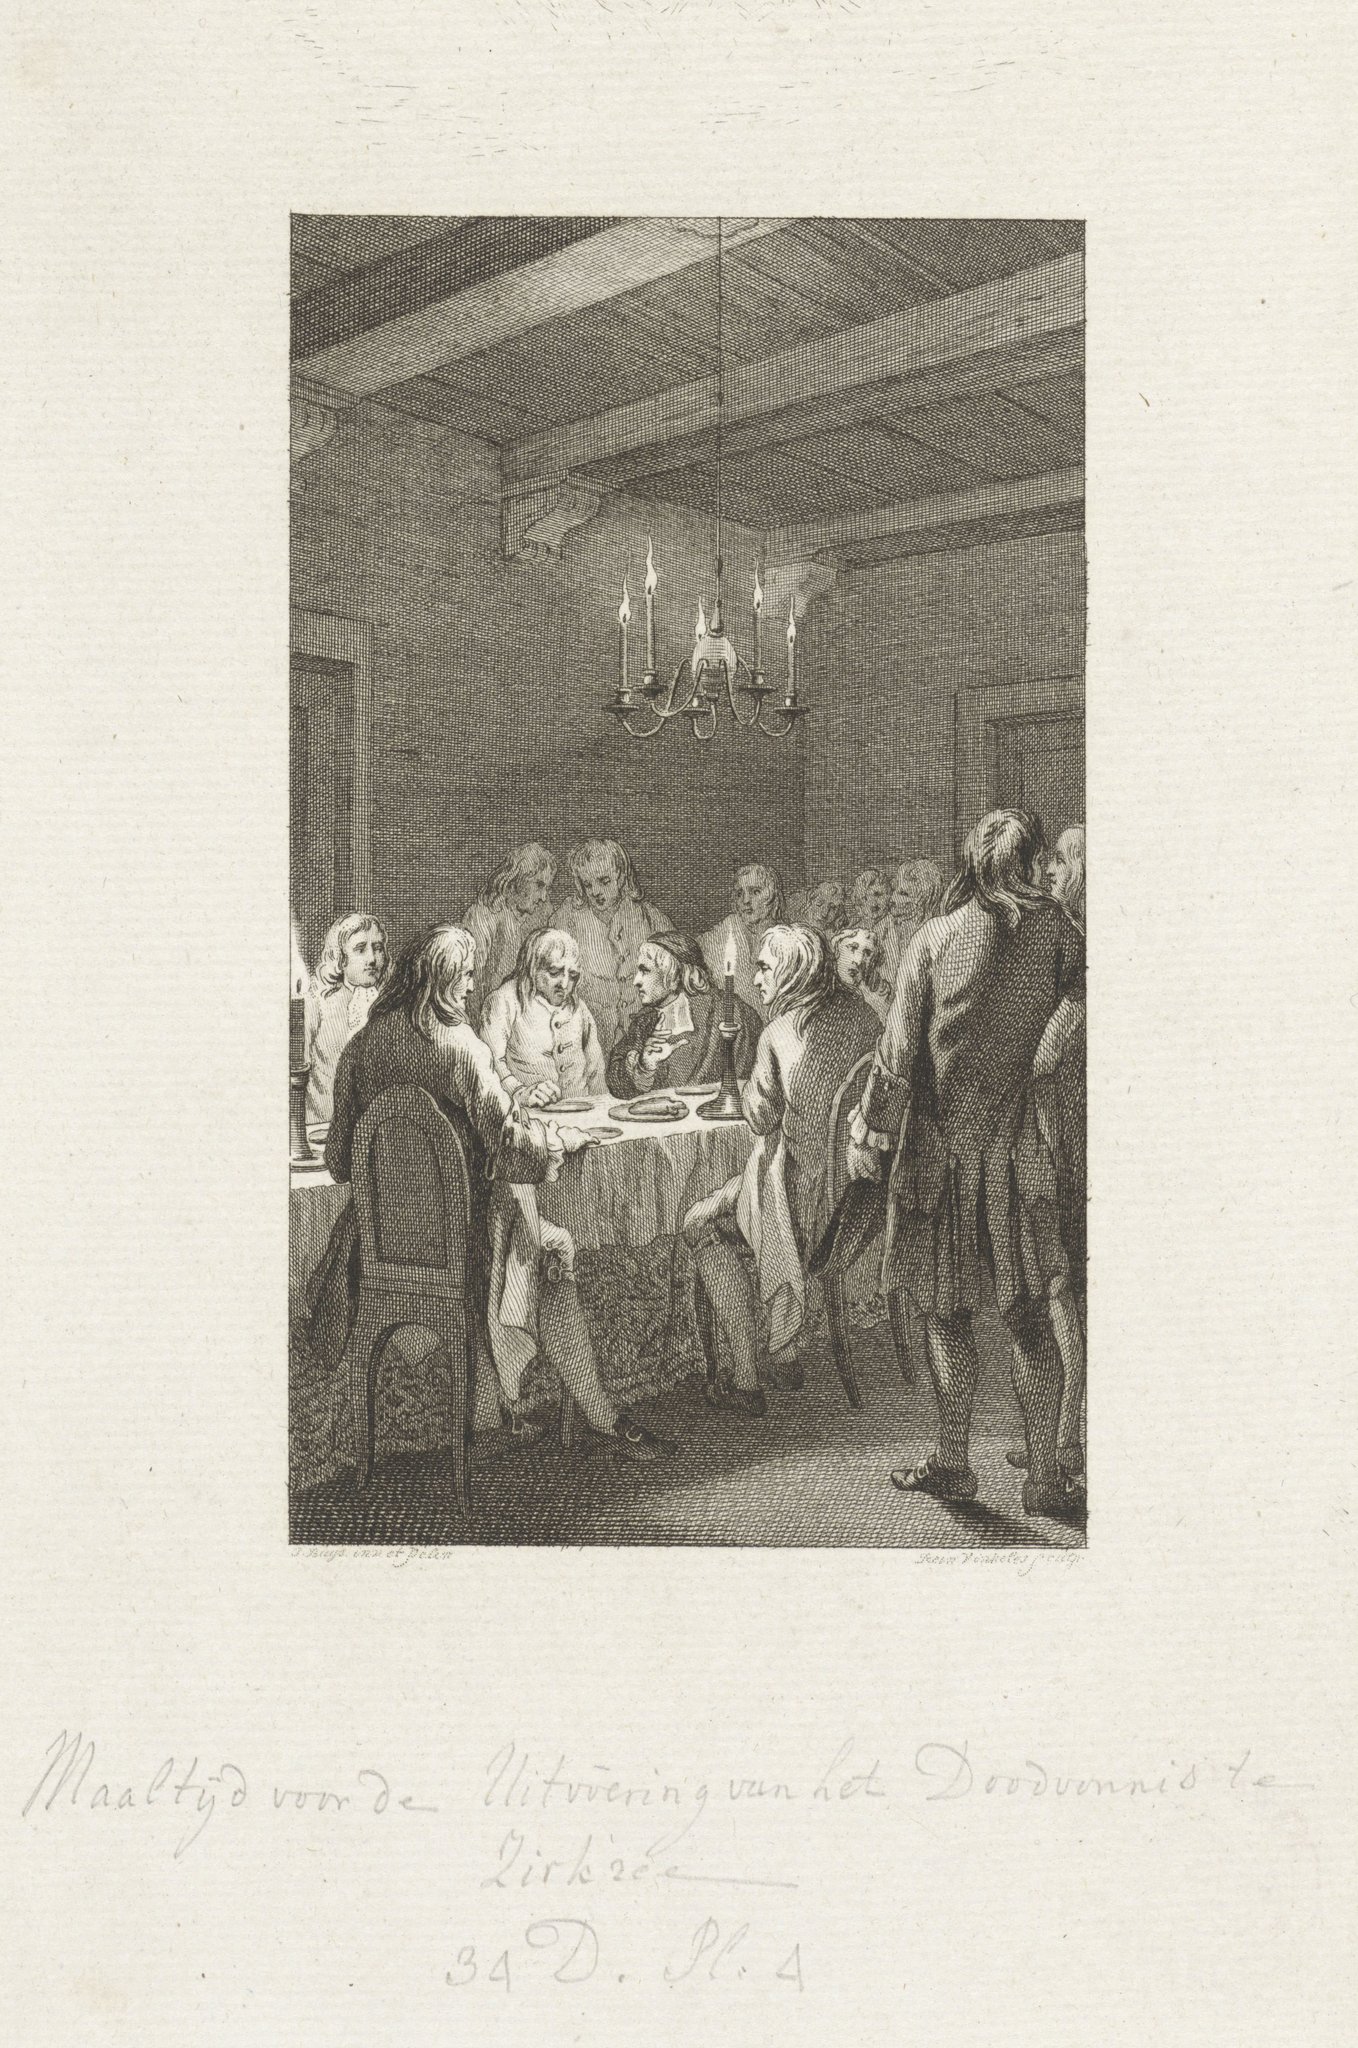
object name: print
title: Galgenmaal te Zierikzee, 1739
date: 1795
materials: paper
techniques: engraving, etching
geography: northern netherlands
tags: last hours before execution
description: Gebruikt als illustratie in: Jacobus Kok, Vaderlandsch Woordenboek, Johannes Allart, Amsterdam 1785-1799, 35 delen, dl. 34, pl. 4.